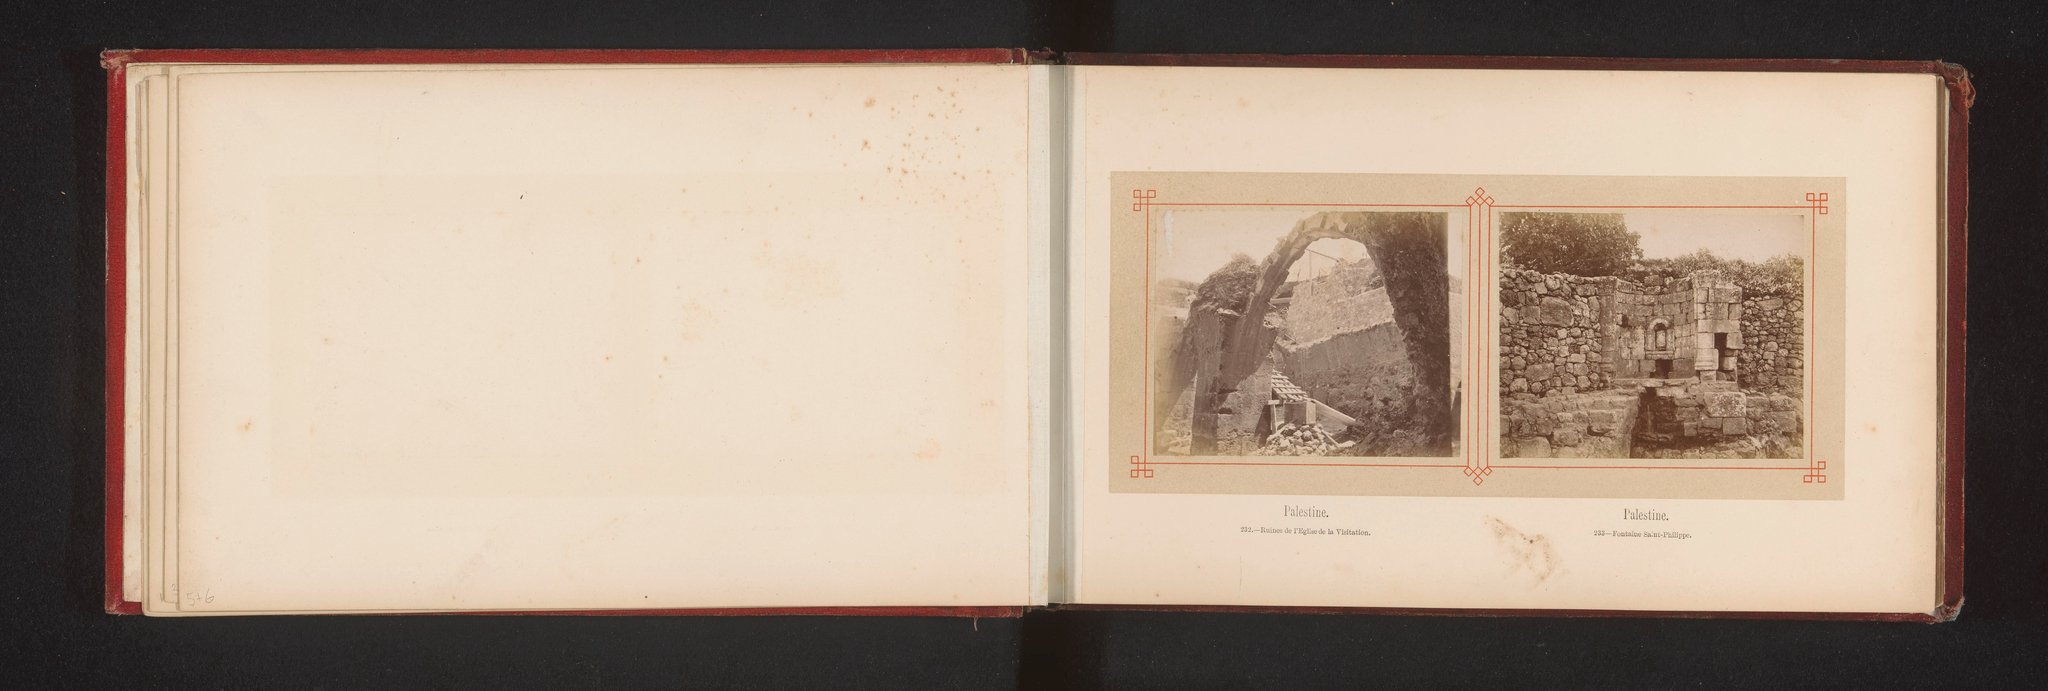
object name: photograph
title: Palestine - 232. - Ruines de l'Eglise de la Visitation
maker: félix bonfils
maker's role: fotograaf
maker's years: 1831-1885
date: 1873-1878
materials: photographic support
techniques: albumen print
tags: ruin of a building ~ architecture